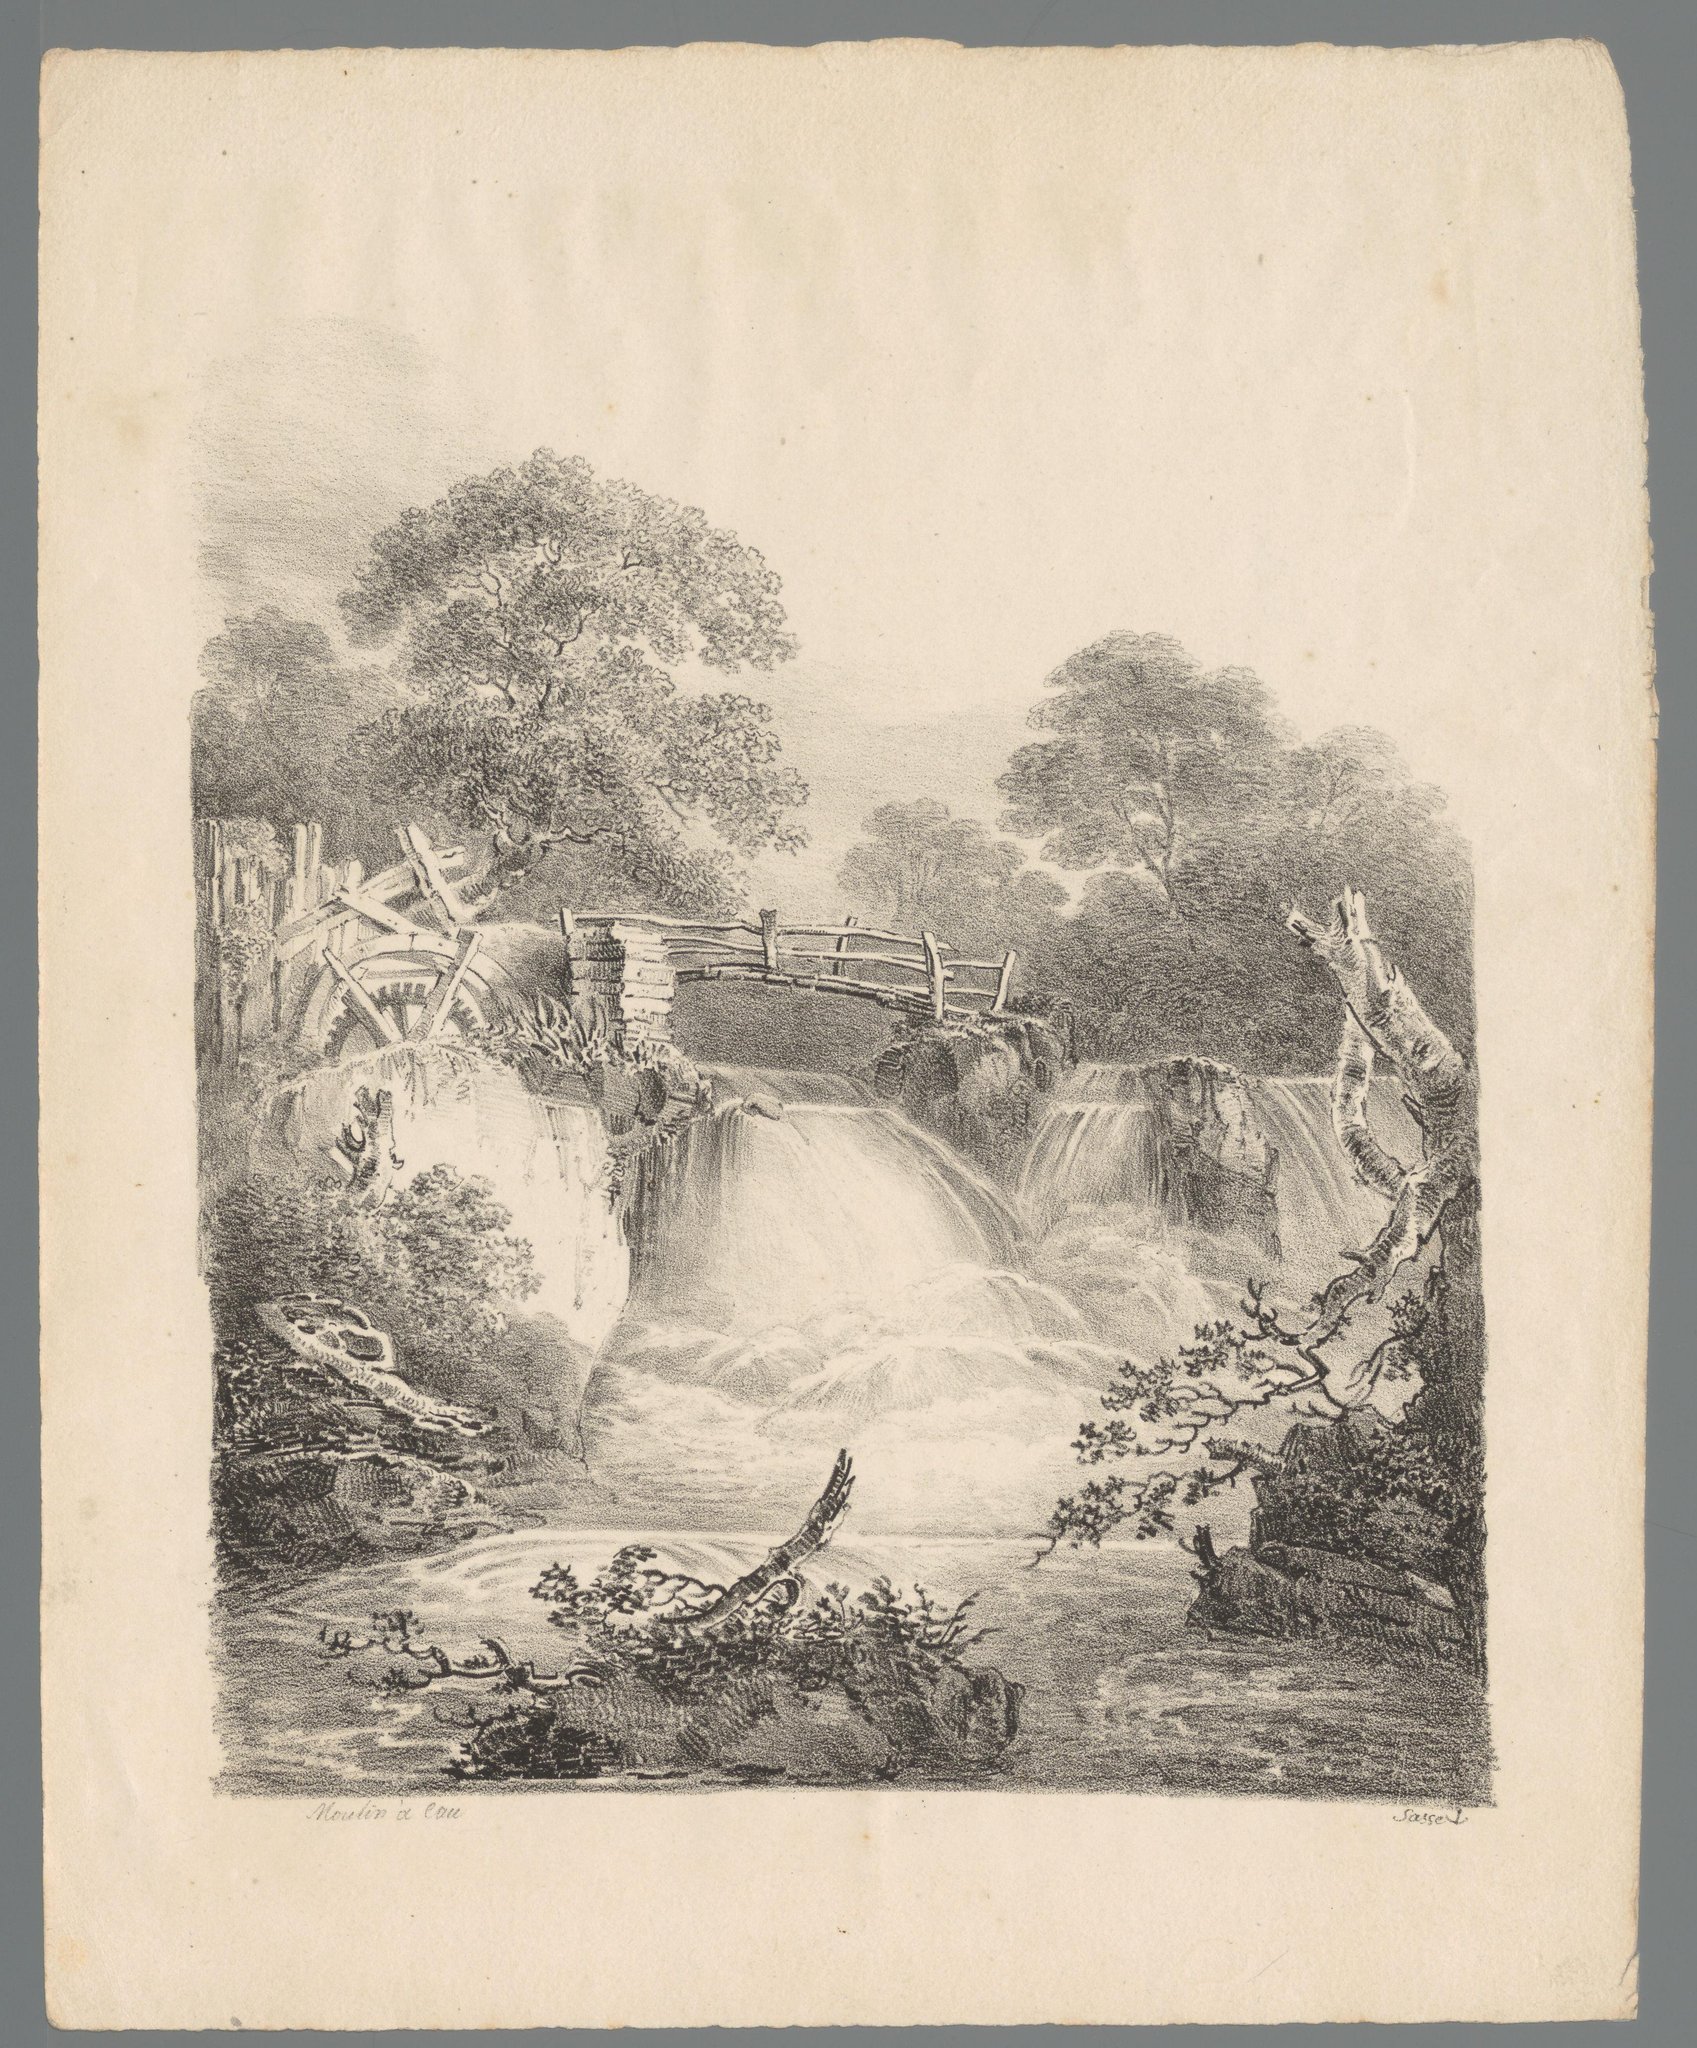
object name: print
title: L'art de dessiner le paysage d'apres nature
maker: richard sasse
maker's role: print maker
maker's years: 1774-1849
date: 1800-1849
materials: paper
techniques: lithograph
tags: waterfall, watermill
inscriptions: collector's mark: Lugt 2228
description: Prent behoort tot de serie 'L'art de dessiner le paysage d'apres nature'. Deze serie is in tien delen met elk zes lithografieën uitgegeven.